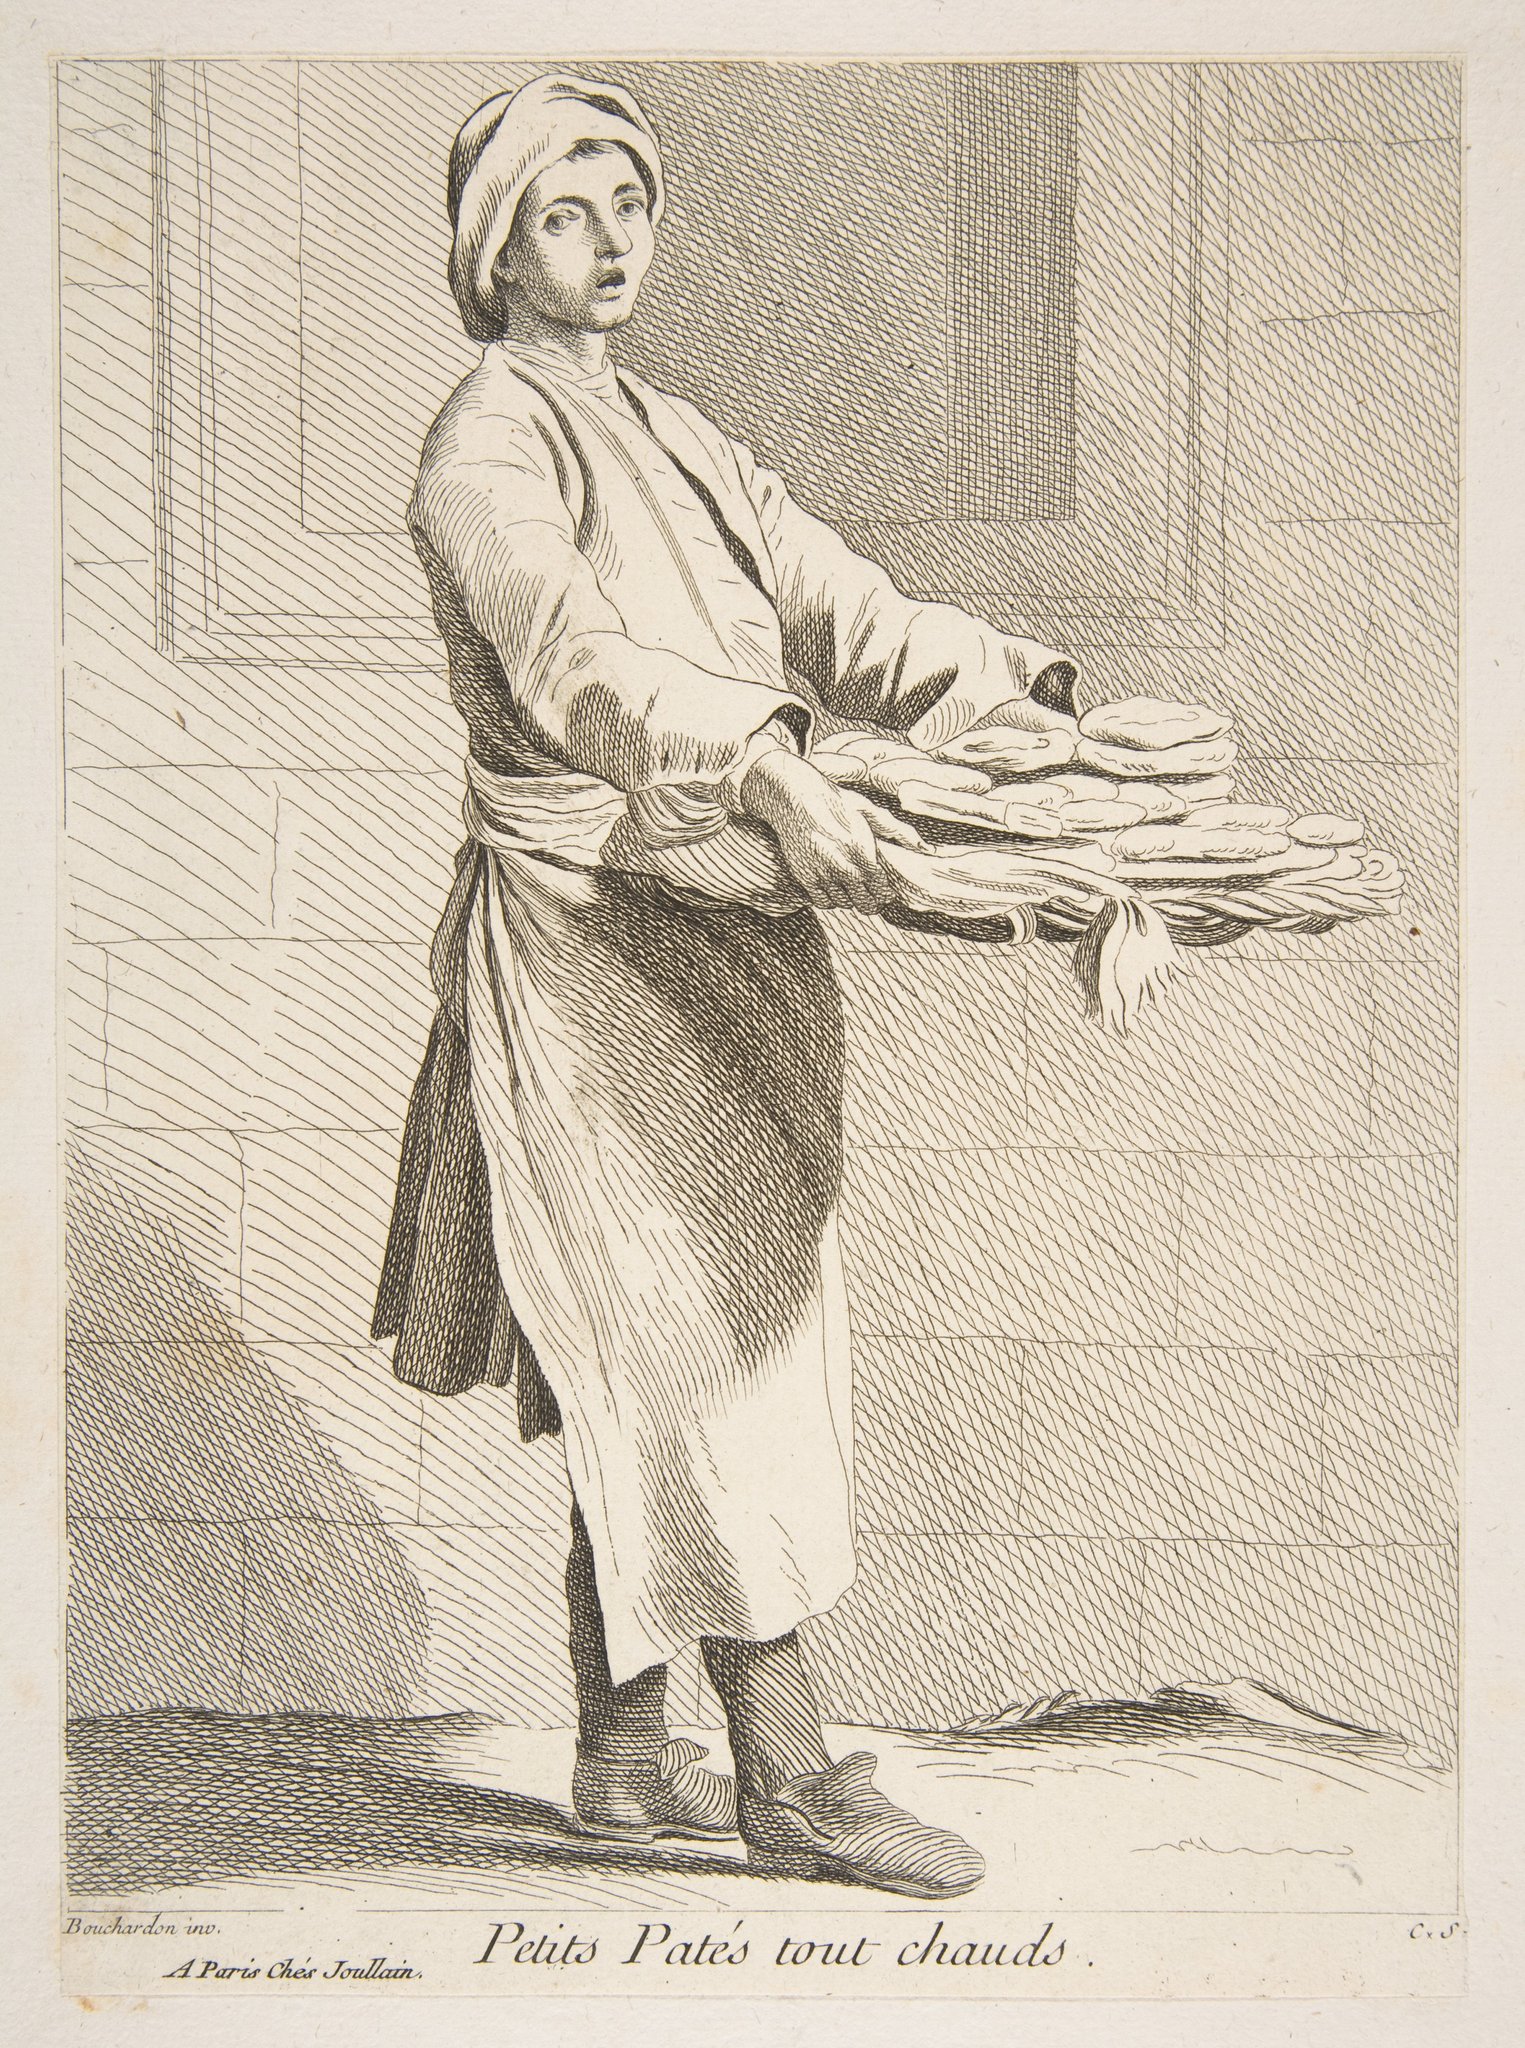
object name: print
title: Pastry Seller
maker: anne claude philippe de tubières, comte de caylus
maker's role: artist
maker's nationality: french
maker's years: 1692-1765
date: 1738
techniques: engraving, etching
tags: food,men